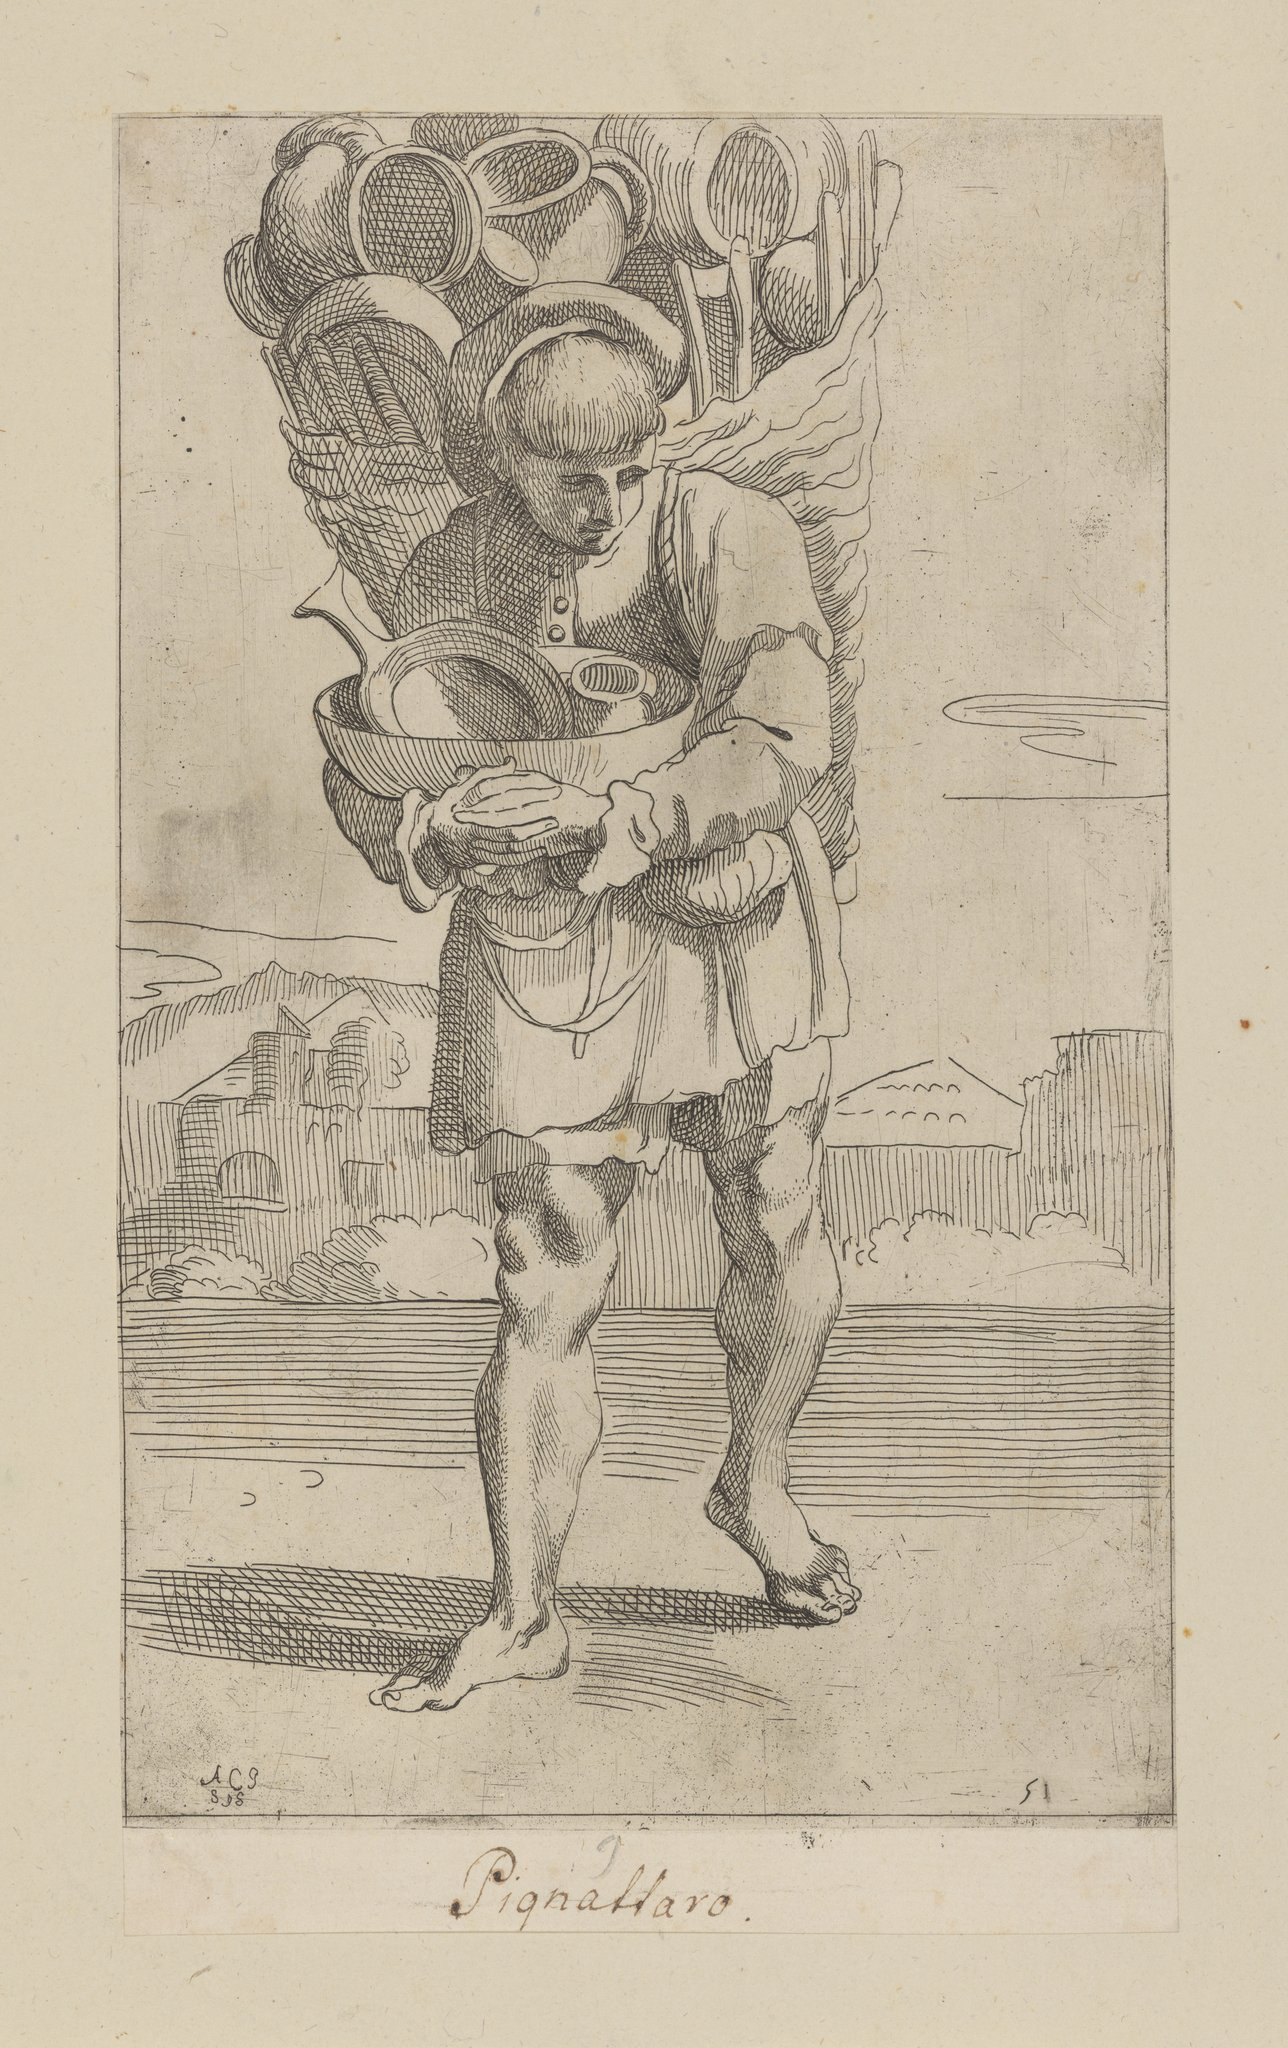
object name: print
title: Plate 5: Pottery vendor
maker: simon guillain ii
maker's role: artist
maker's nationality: french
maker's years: 1618-1718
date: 1646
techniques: etching